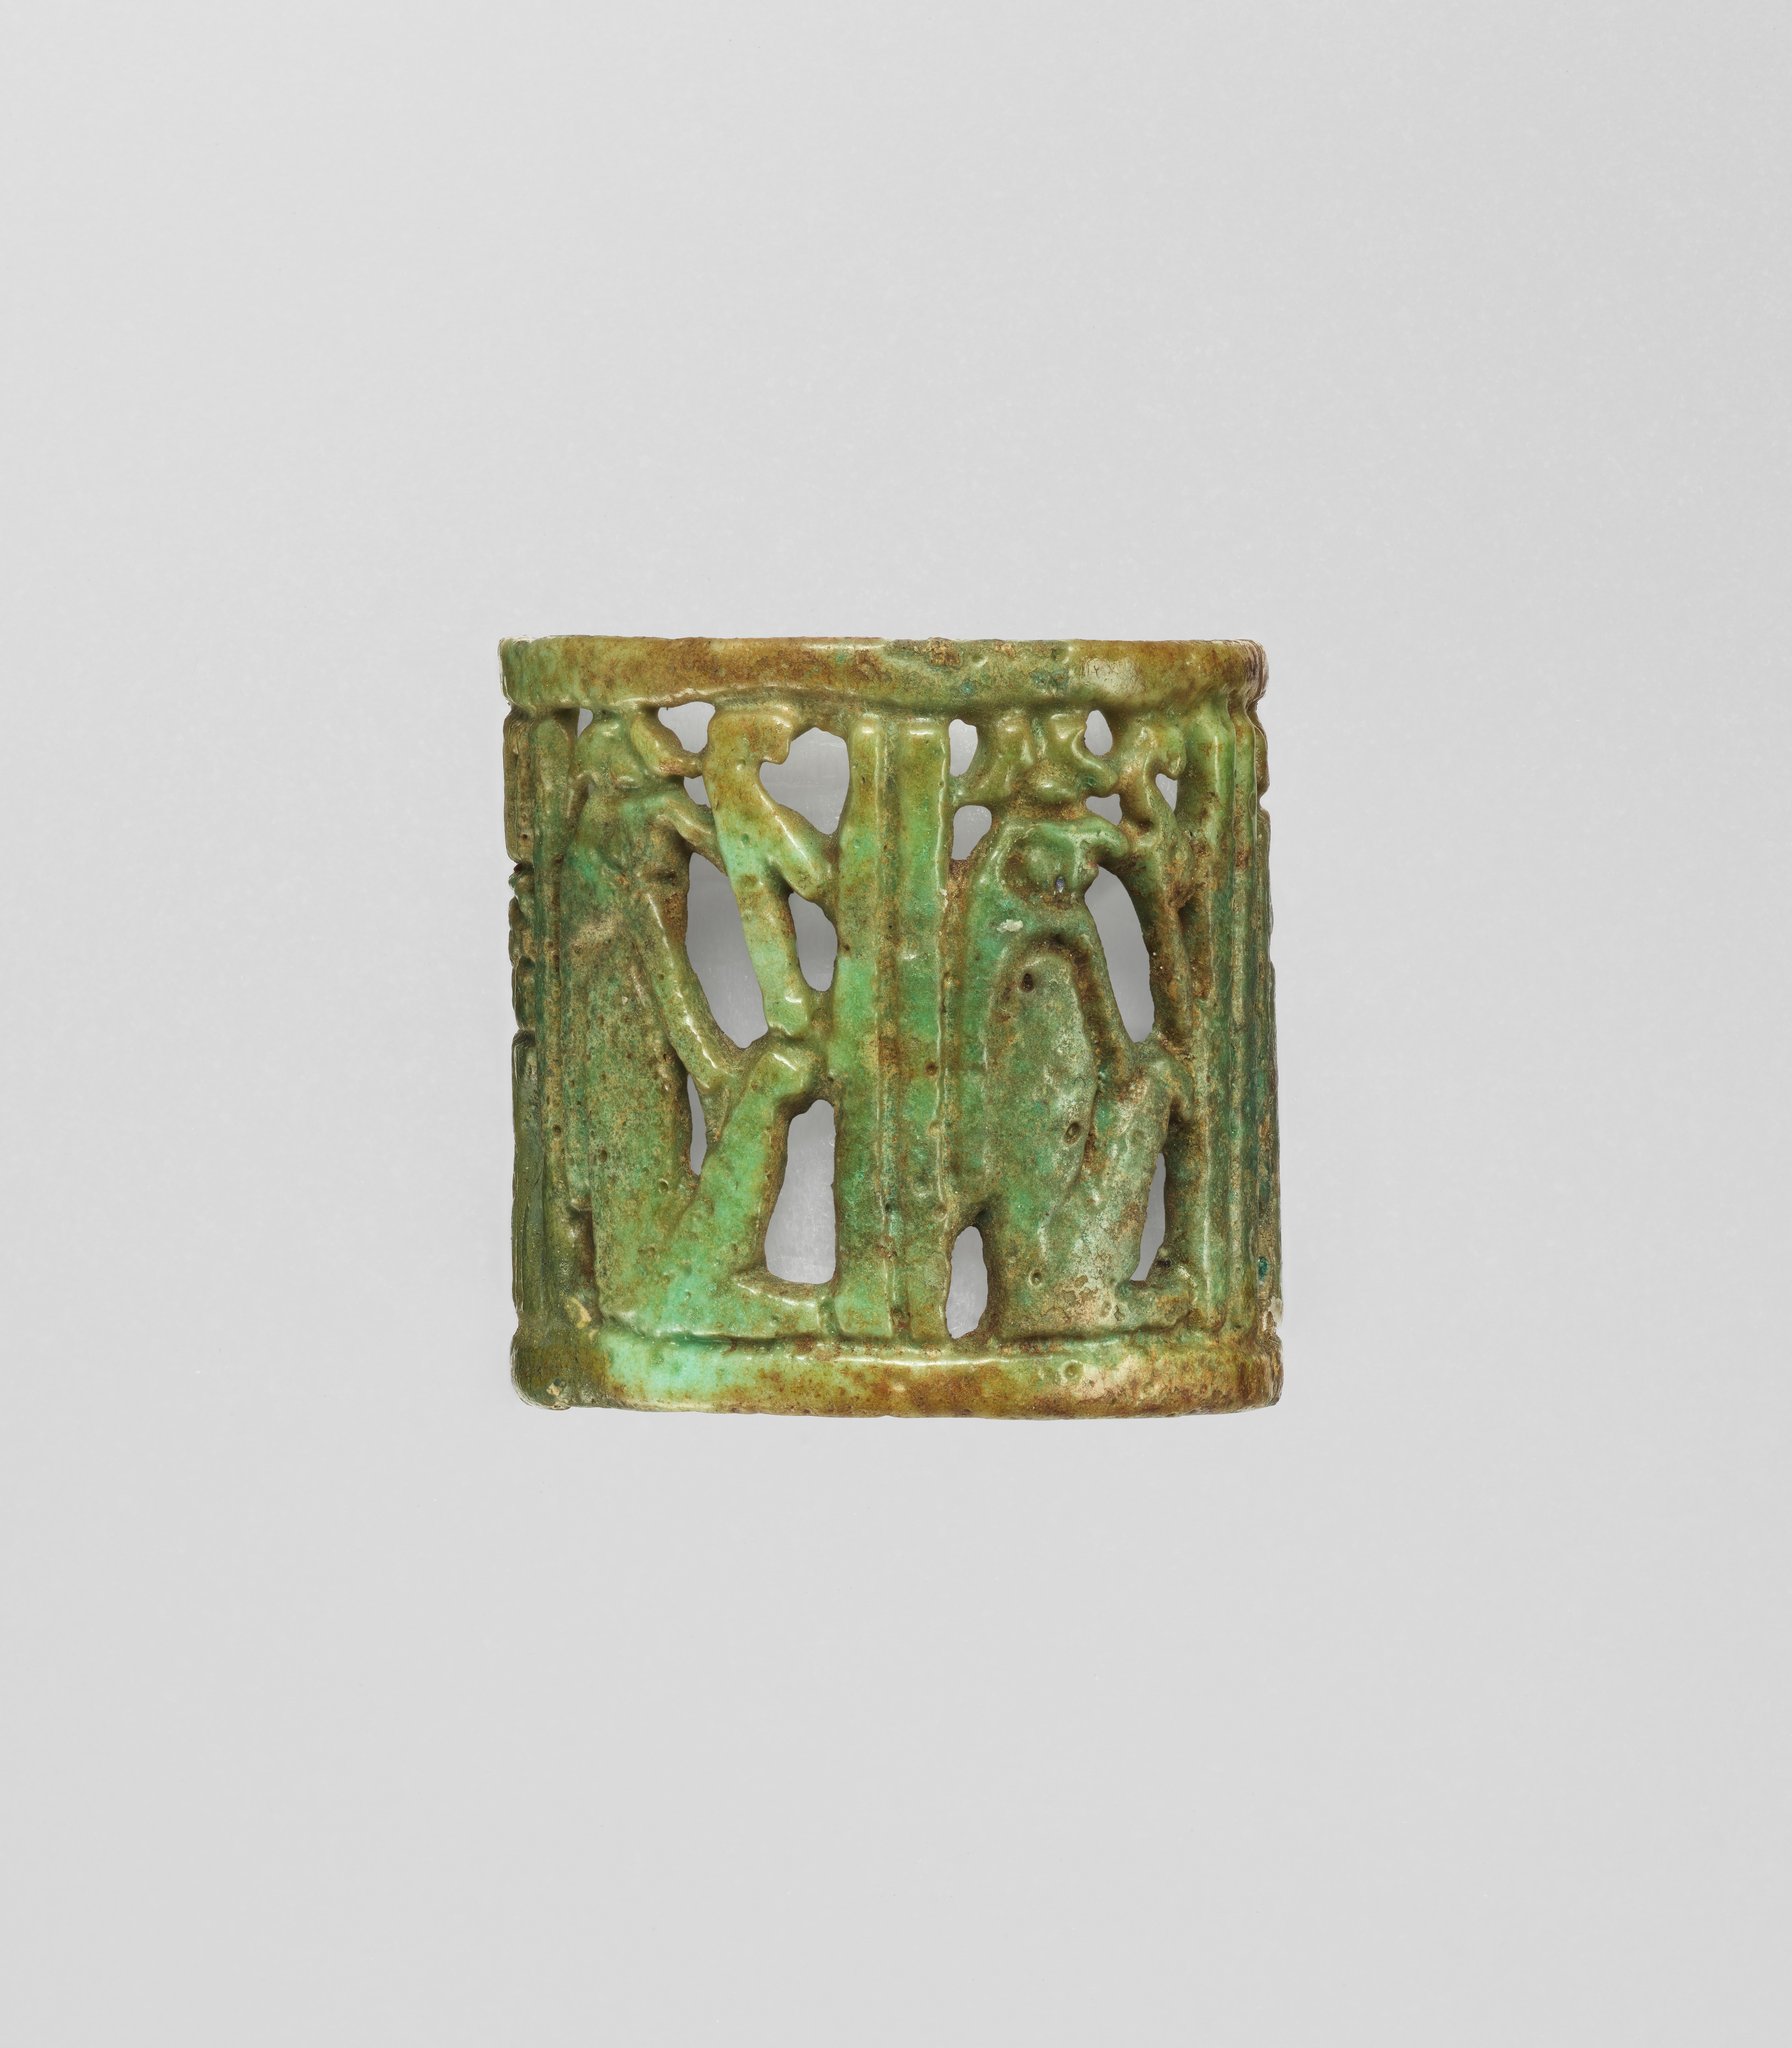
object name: ring, openwork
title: Ring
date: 1070-712 BCE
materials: faience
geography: egypt